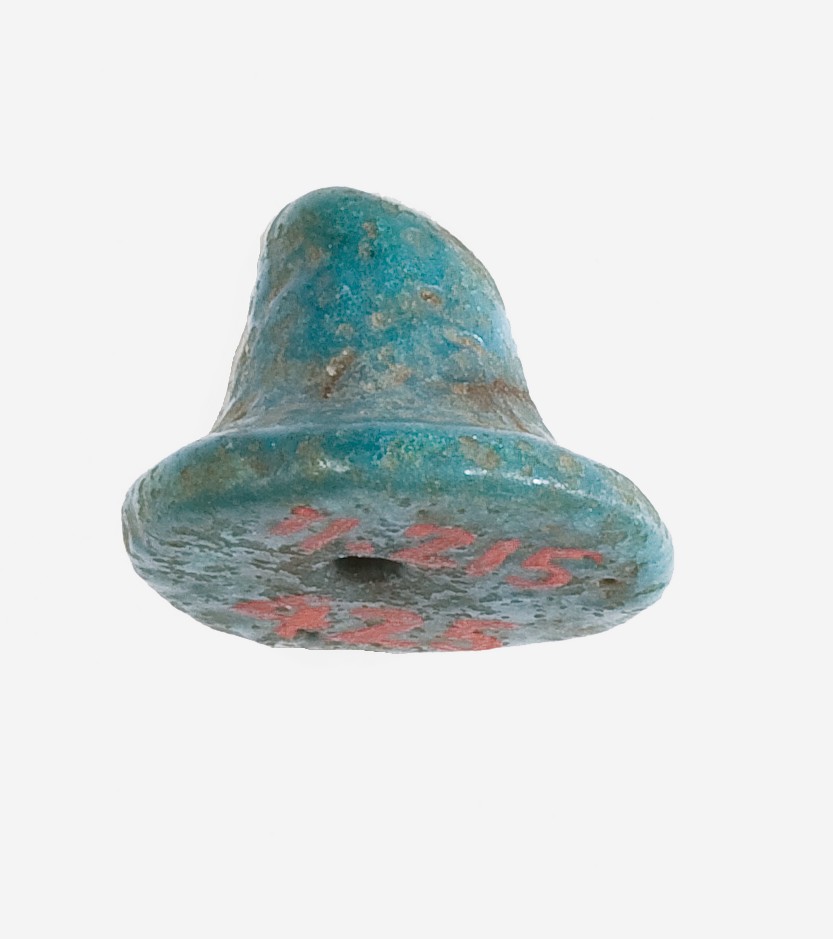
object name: pendant, umbel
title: Umbel Pendant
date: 1390-1352 BCE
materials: faience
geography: egypt